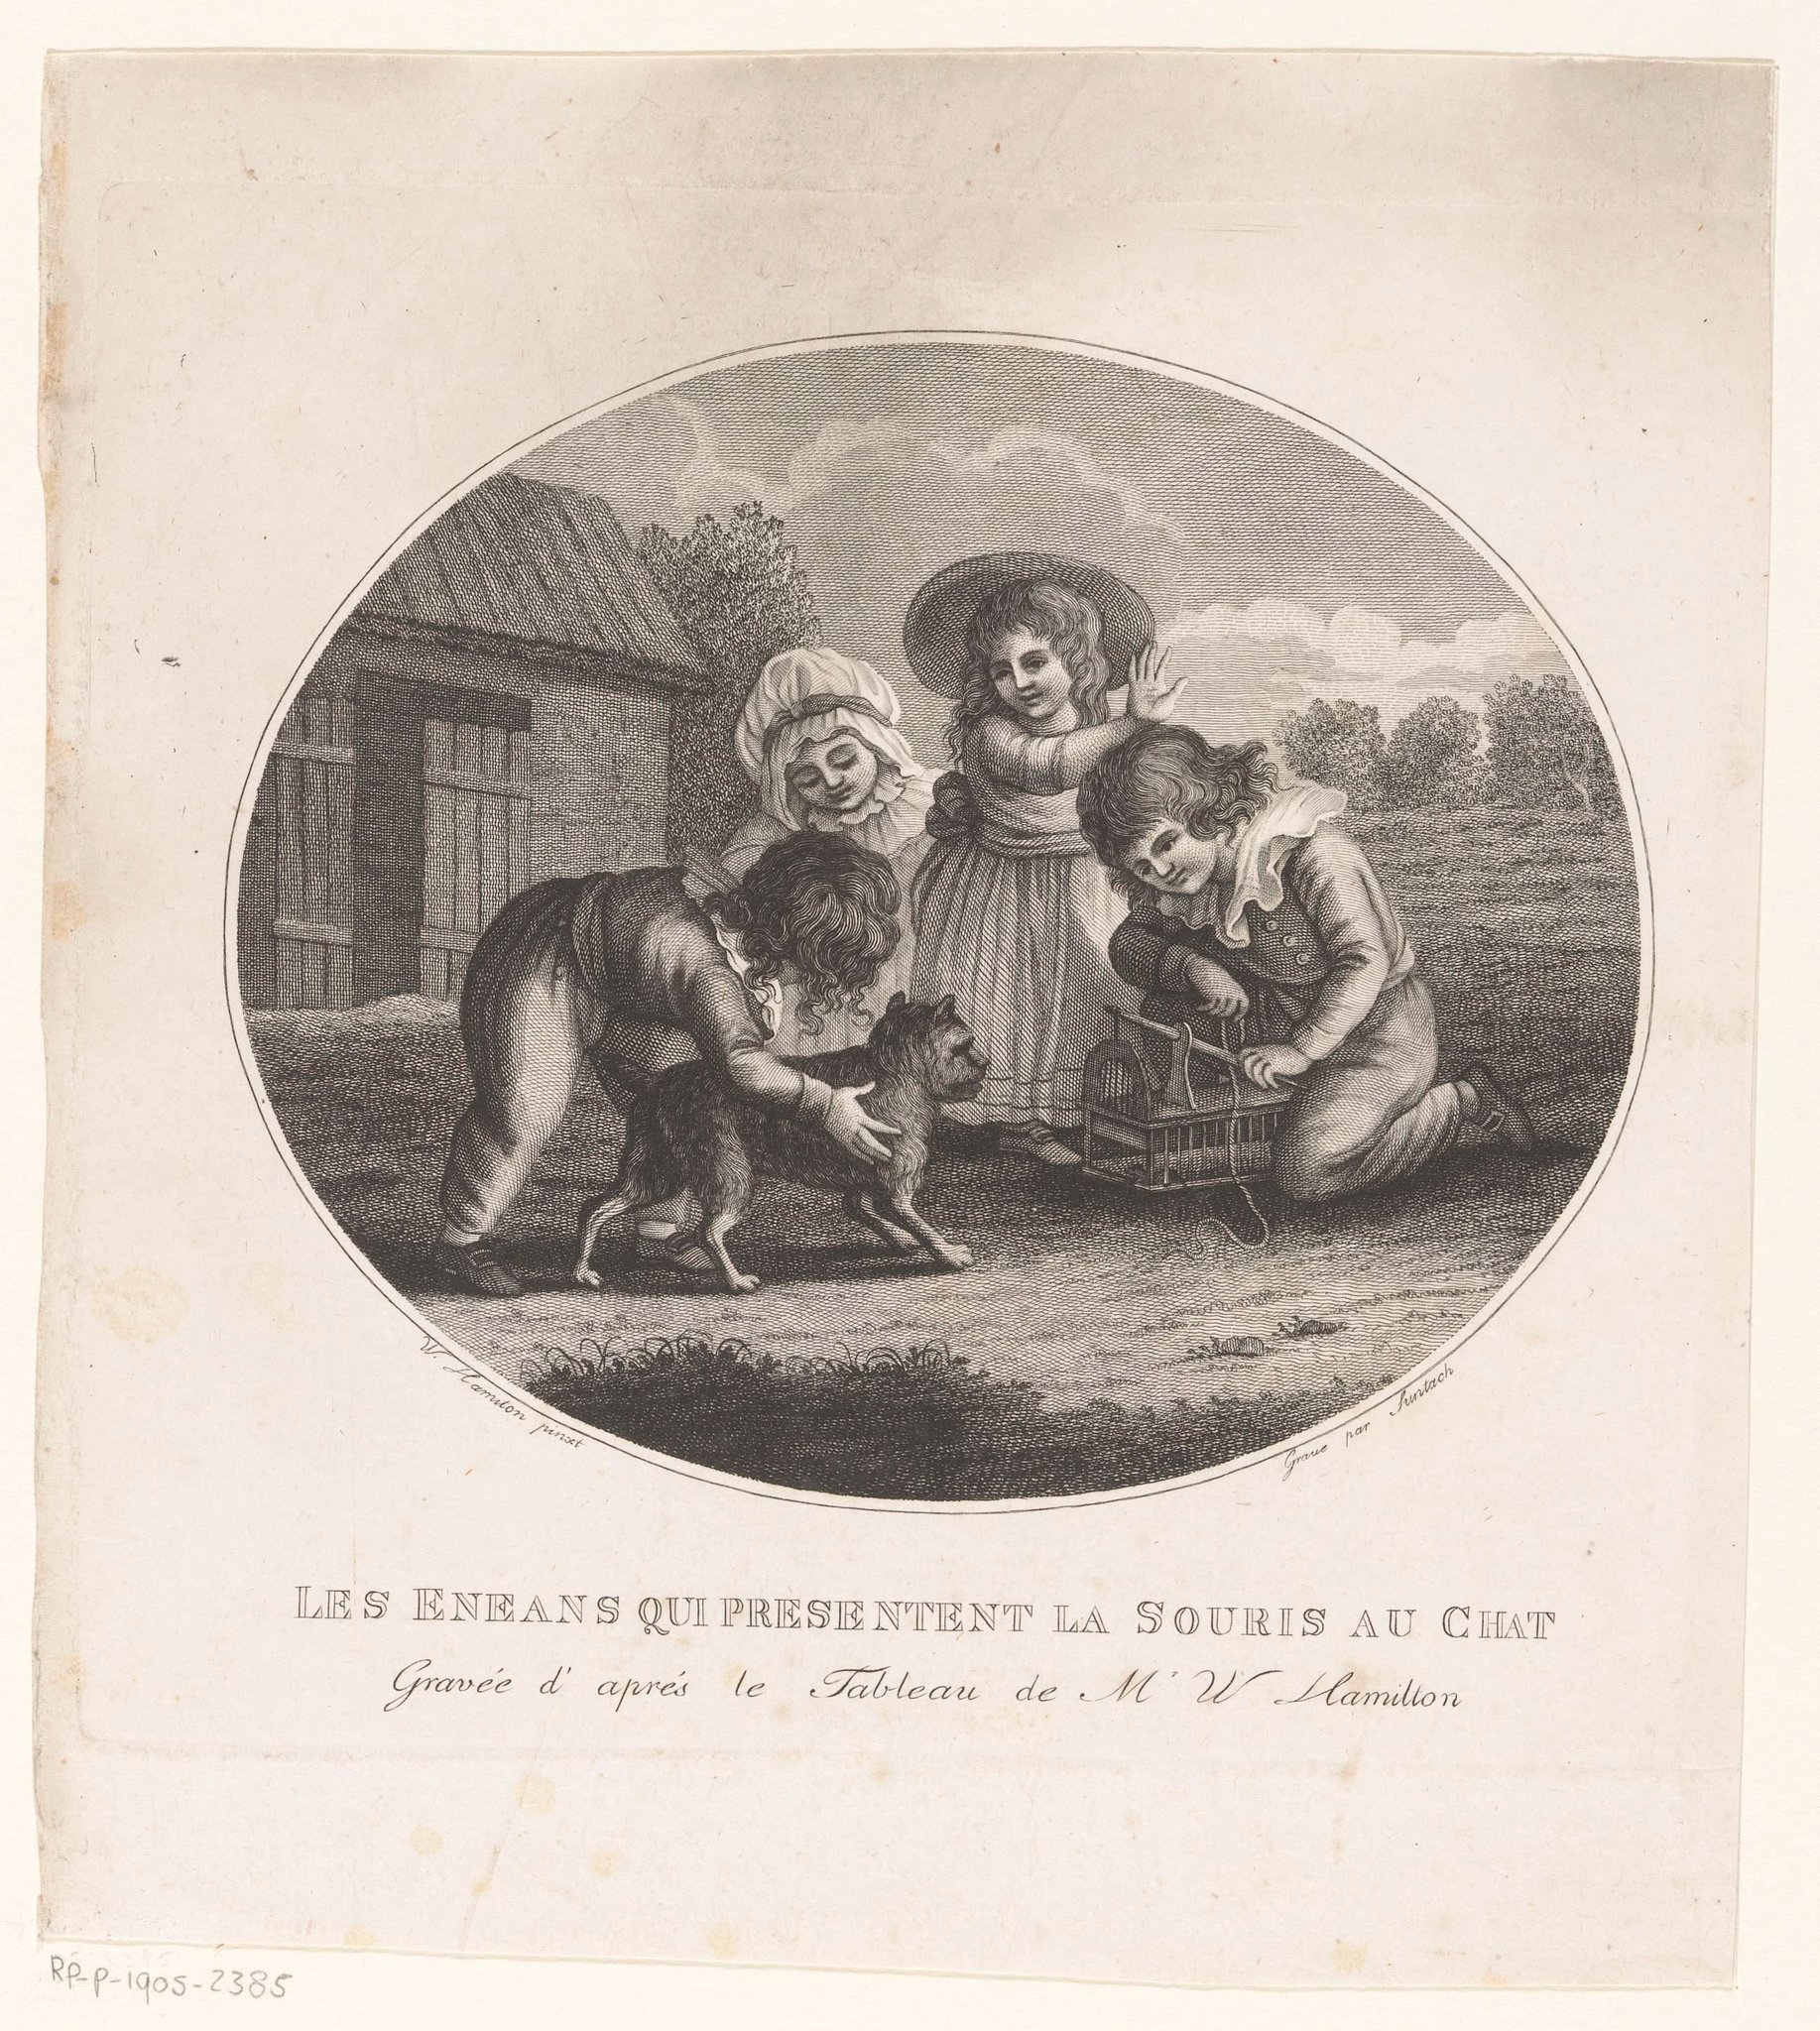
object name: print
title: Kinderspelen naar schilderijen van William Hamilton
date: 1754-1842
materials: paper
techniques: engraving, etching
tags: children's games and plays, cat and mouse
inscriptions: collector's mark: Lugt 2228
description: Links houdt een van de kinderen een kat vast. Rechts opent een ander kind een kleine klooi met daarin een muis.